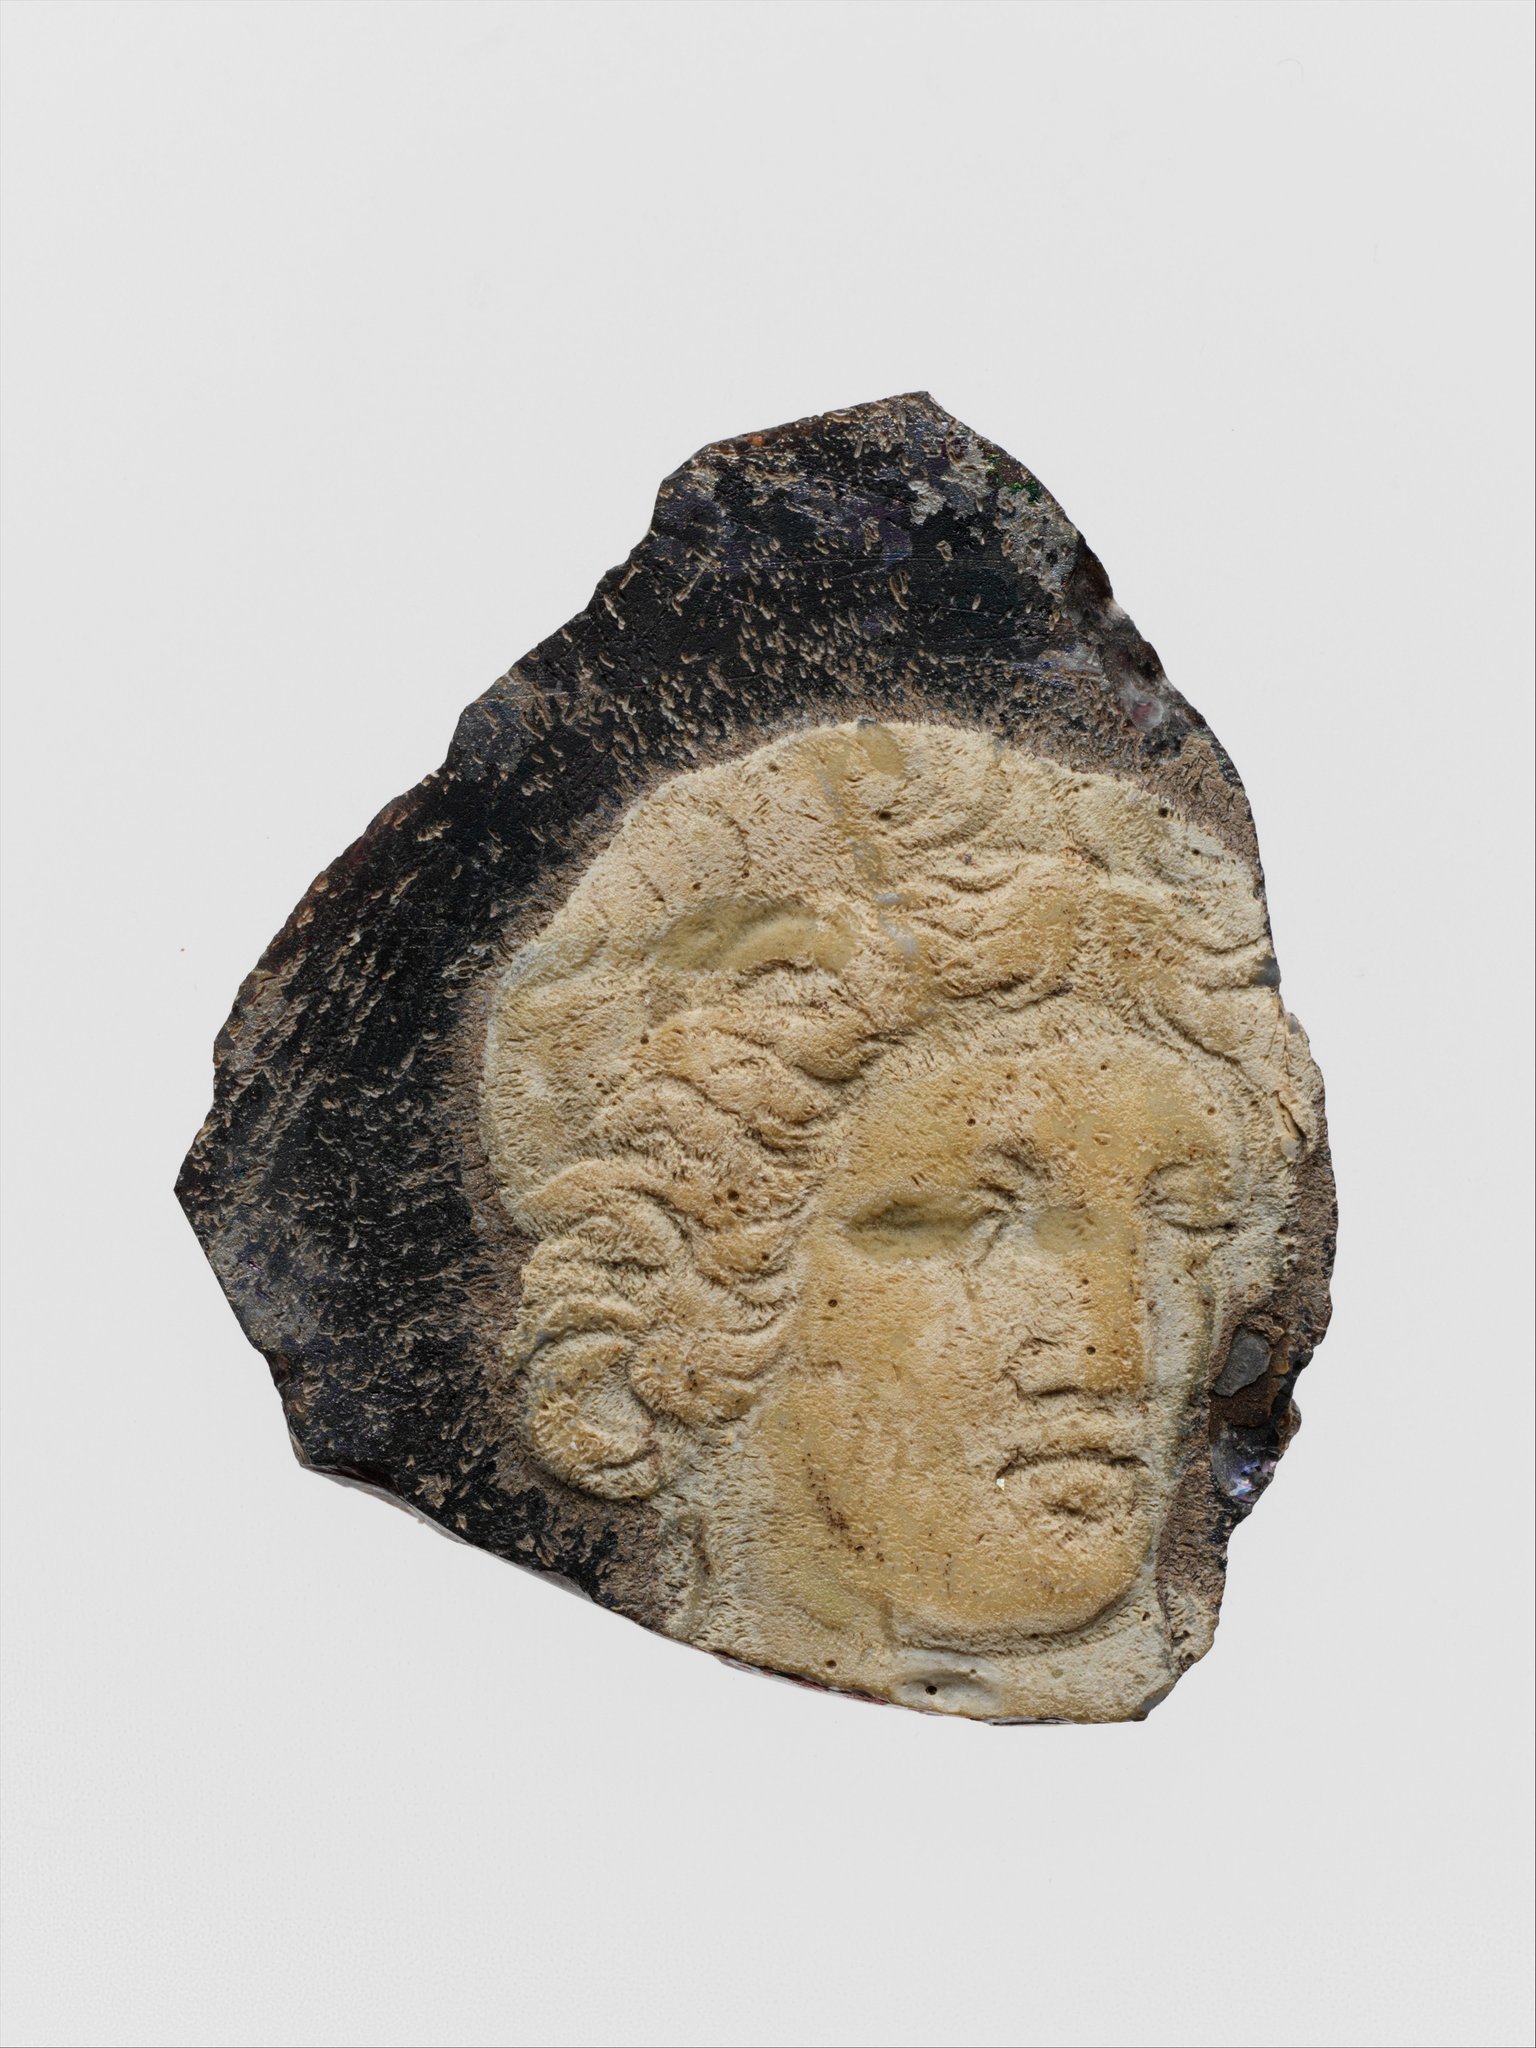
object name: cameo plaque fragment, head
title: Glass cameo plaque fragment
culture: roman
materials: glass, paste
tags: heads